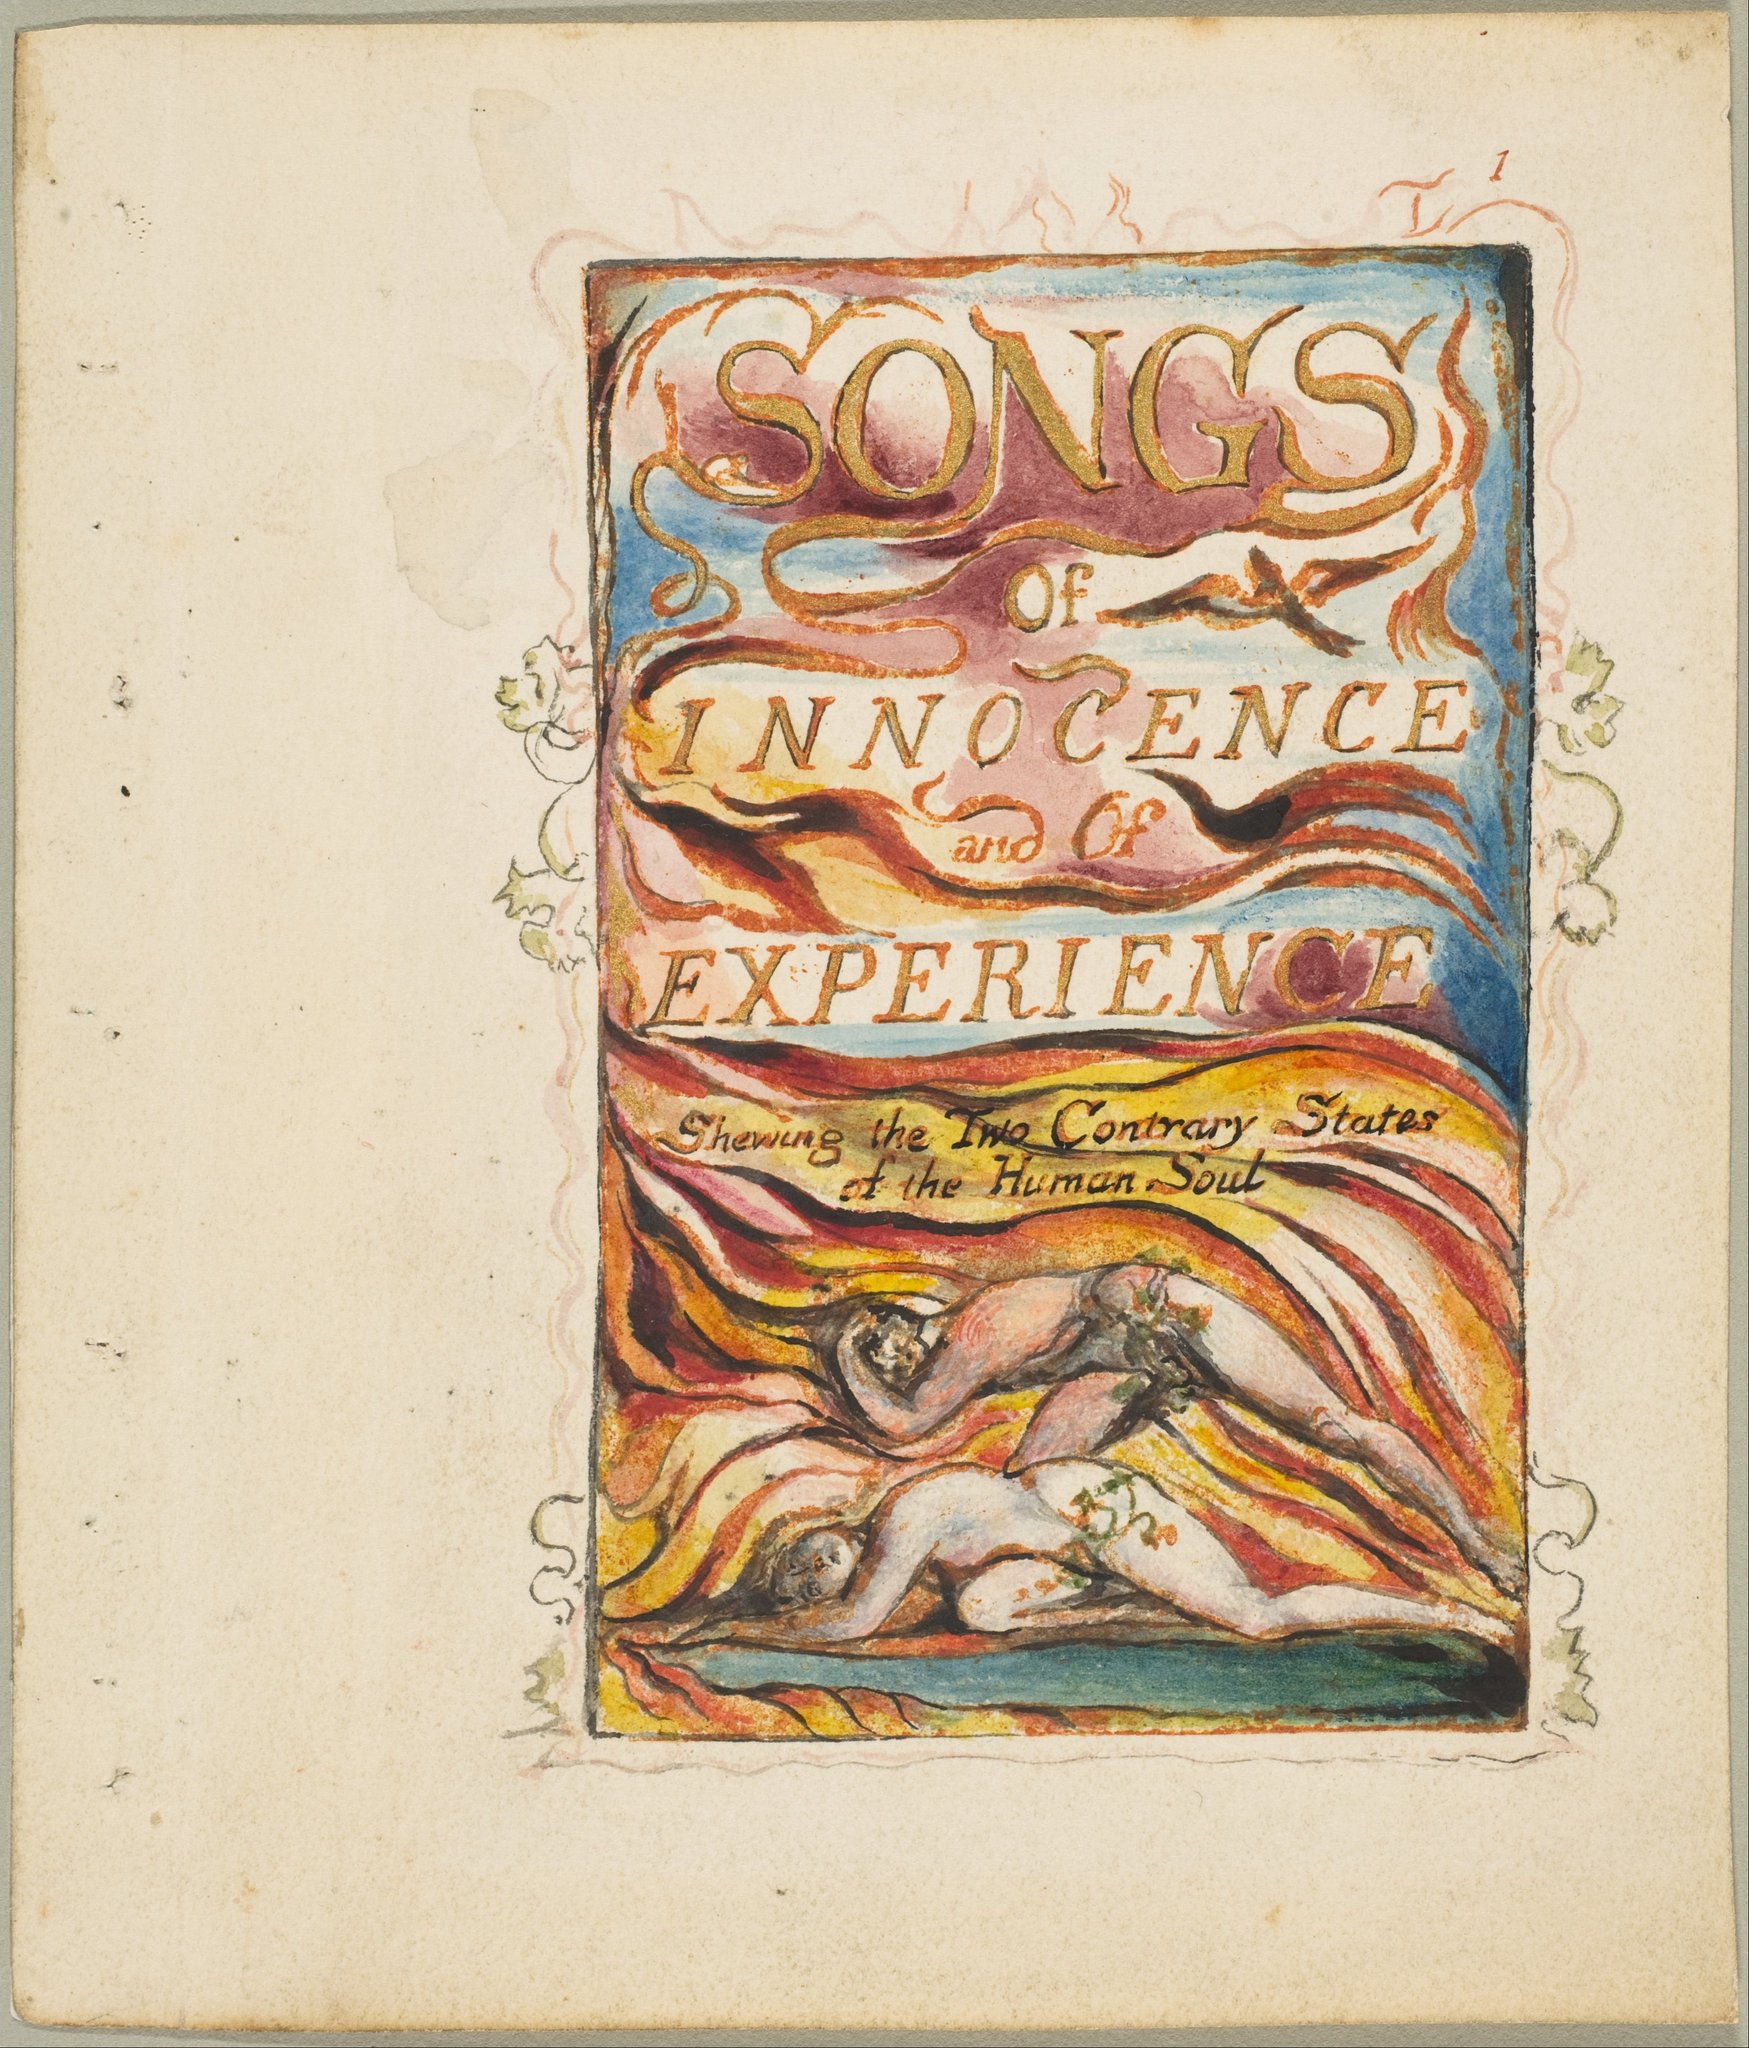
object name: print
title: Songs of Innocence and of Experience, Shewing the Two Contrary States of the Human Soul: Combined Title-page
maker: william blake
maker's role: artist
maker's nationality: british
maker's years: 1757-1827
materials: gold, ink, shell, watercolor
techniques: etching, hand coloring, printing, relief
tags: male nudes,female nudes